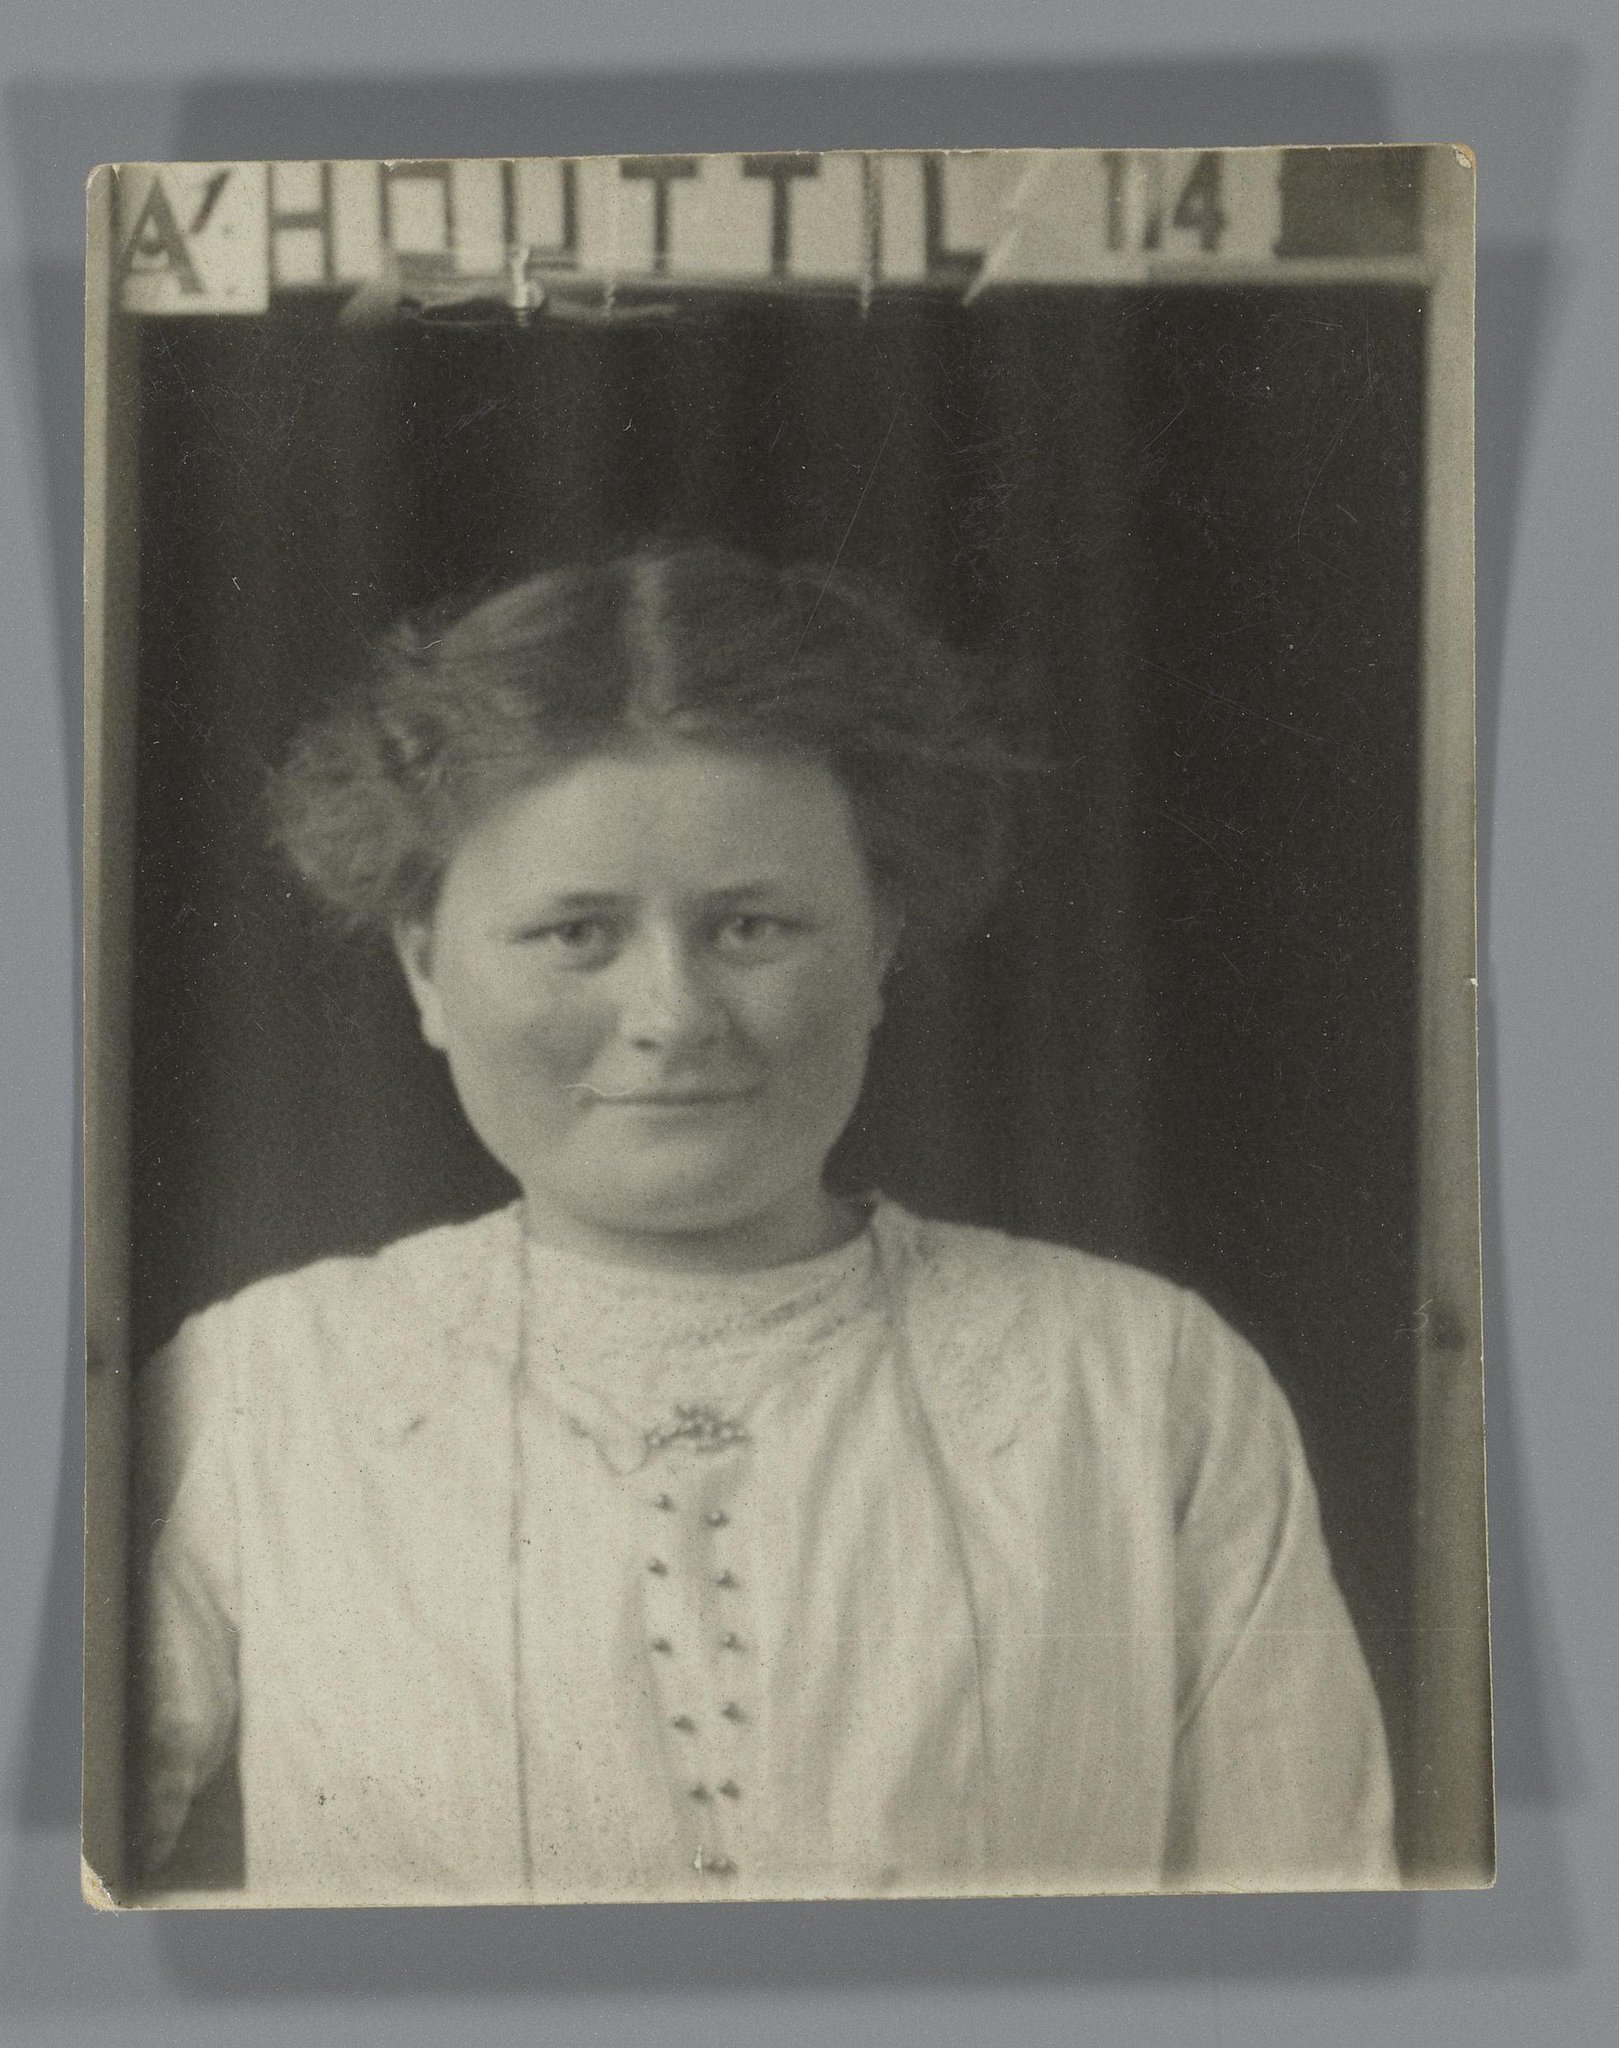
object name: snapshot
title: Rapid photographs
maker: jan gottfried stütner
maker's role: fotograaf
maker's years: 1892-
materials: photographic support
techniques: gelatin silver print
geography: alkmaar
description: Between 1912 and 1930, anyone could have their portrait taken at the many so-called rapid photography studios in the shopping streets of mainly (medium) large-size European cities. As if on an assembly line, the youngest clerk shot the photographs with a special camera and in artificial light and developed them. Later in the day, the customer collected a sheet with 12 portrait photos for 25 cents. This form of photographic mass production gave rise to a fascinating tableau of boys, girls, men and women not previously seen in photographs; candid and informal. There were at least 150 quick-photo studios, from Alkmaar to Zutphen. Many called themselves ‘American,’ mistakenly as it turns out because hardly any examples from that country have been found.